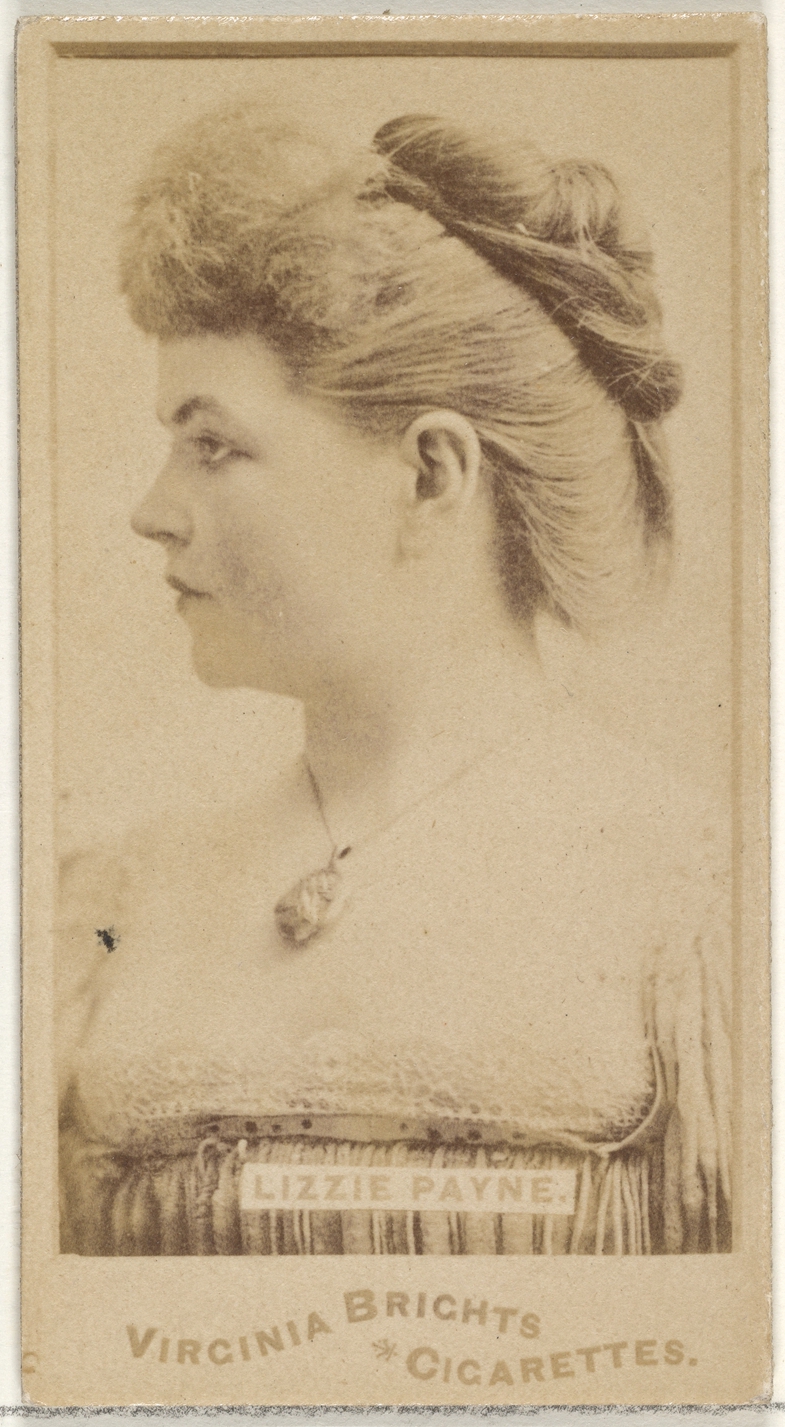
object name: photograph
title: Lizzie Payne, from the Actors and Actresses series (N45, Type 1) for Virginia Brights Cigarettes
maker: allen & ginter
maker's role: publisher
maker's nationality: american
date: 1888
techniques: albumen silver print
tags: portraits,profiles,women,actresses